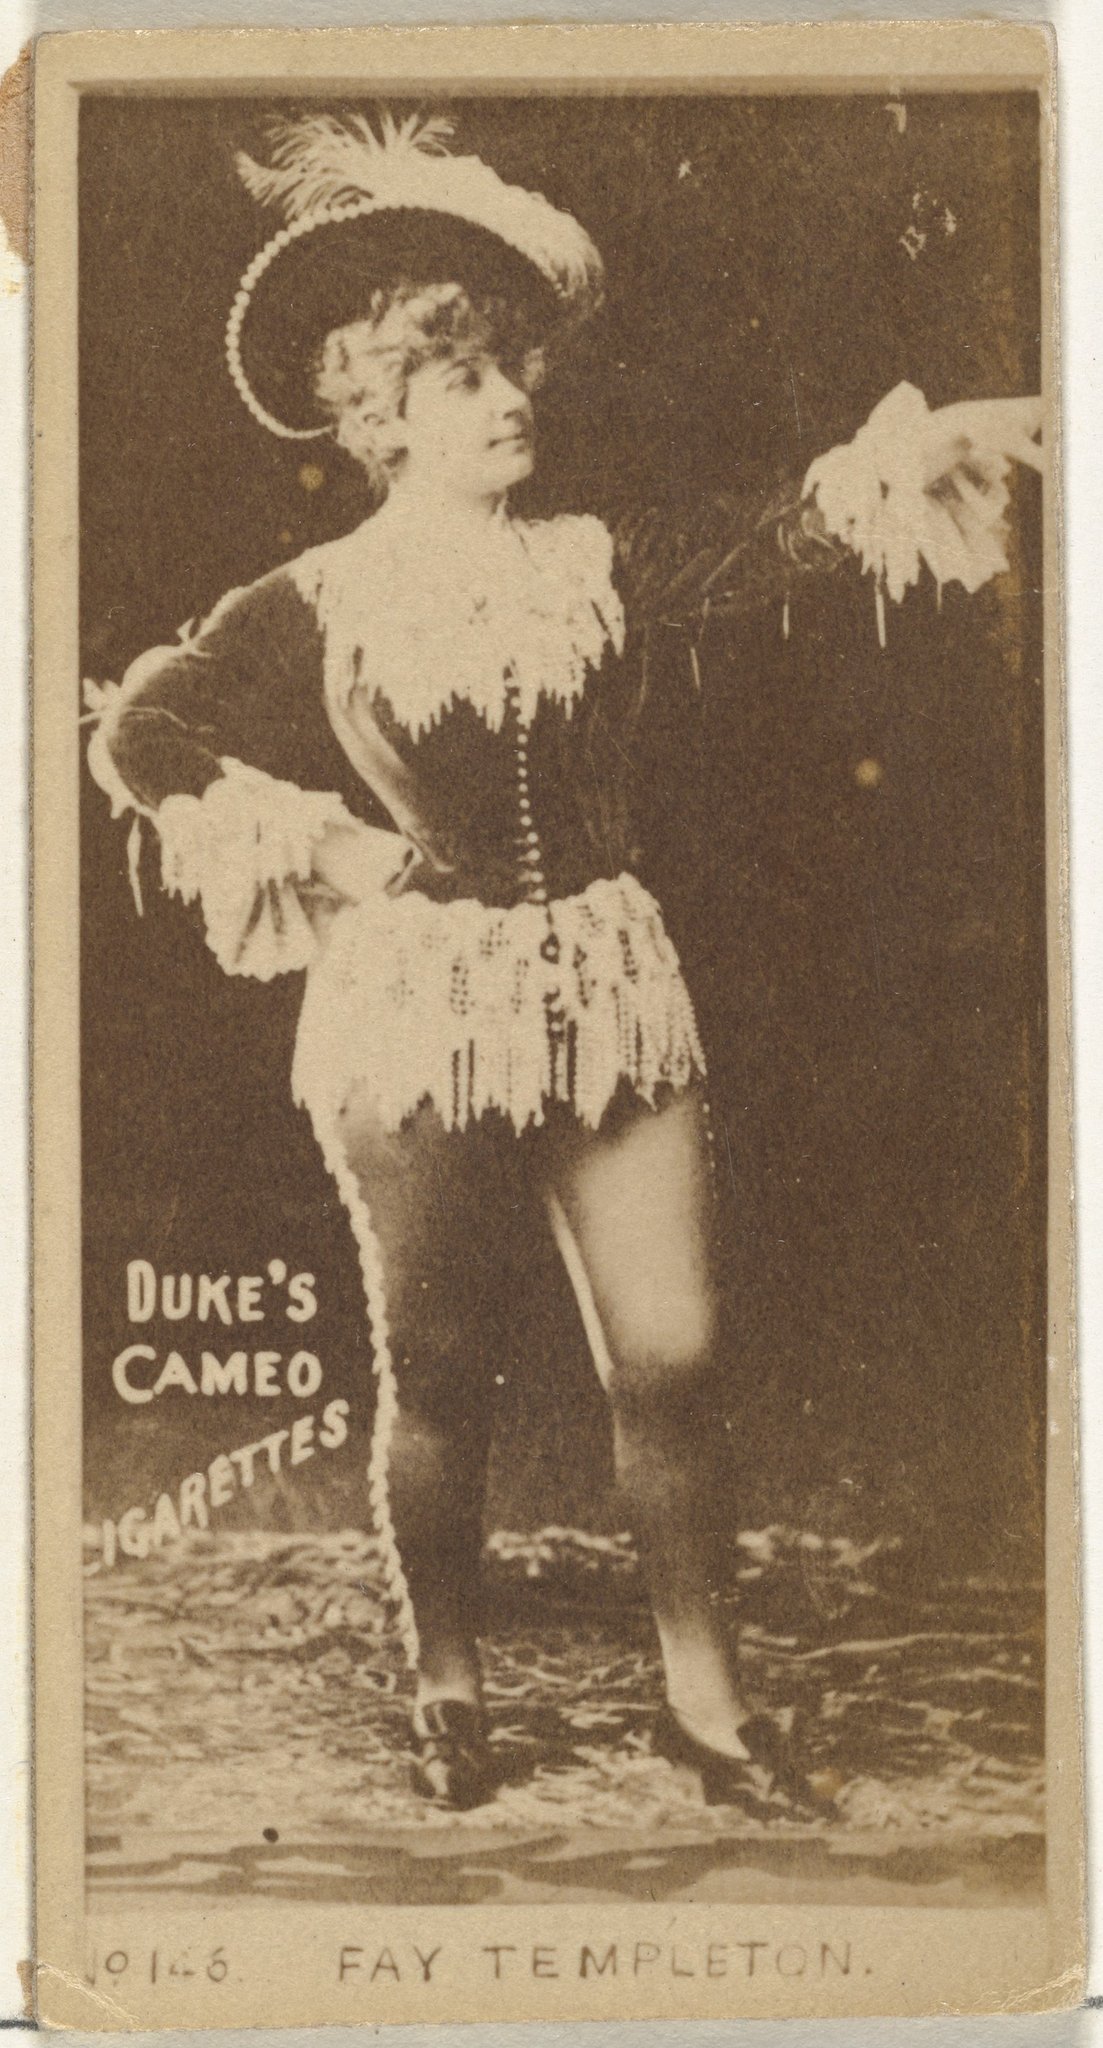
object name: photograph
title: Card Number 146, Fay Templeton, from the Actors and Actresses series (N145-4) issued by Duke Sons & Co. to promote Cameo Cigarettes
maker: w. duke, sons & co.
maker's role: publisher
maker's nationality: american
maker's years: 1870-1920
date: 1880-1889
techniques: albumen silver print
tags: women,actresses